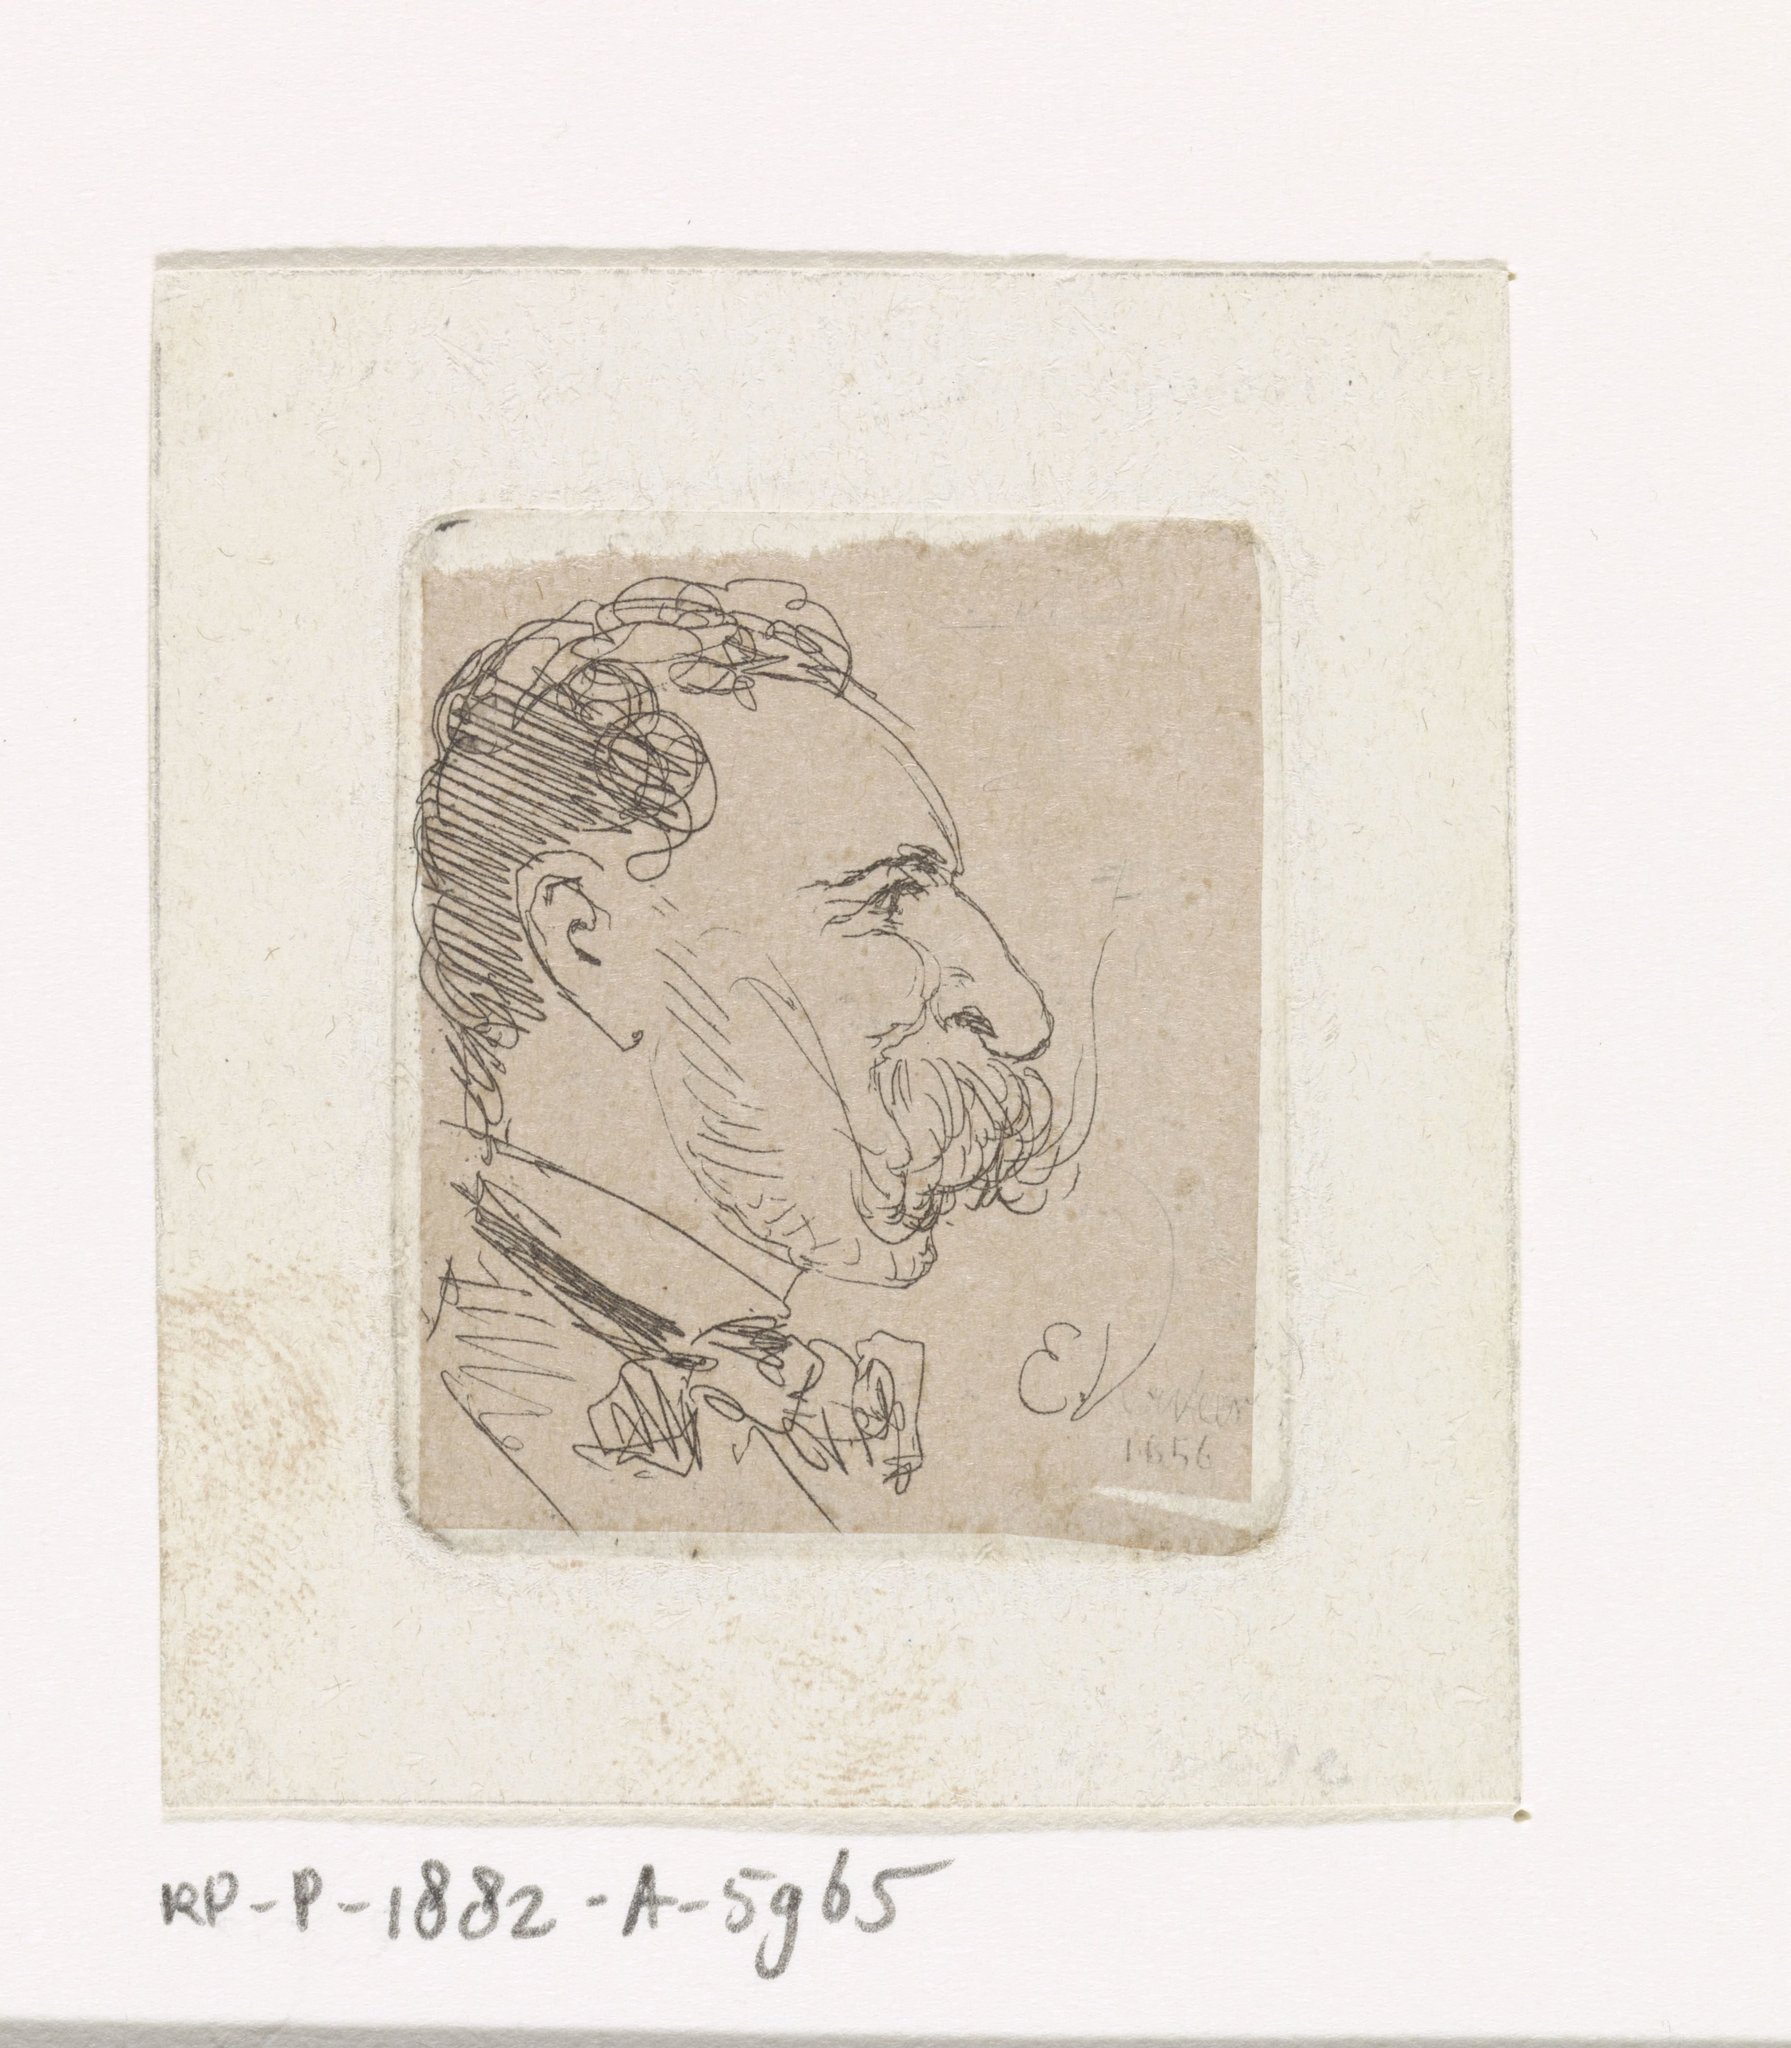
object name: print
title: Portret van Elchanon Verveer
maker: elchanon verveer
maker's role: draughtsman, print maker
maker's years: 1826-1900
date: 1856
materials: paper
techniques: etching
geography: the hague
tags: the hague, print maker, draughtsman, elchanon verveer, moustache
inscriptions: collector's mark: Lugt 2228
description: Zelfportret naar rechts van de kunstenaar Elchanon Verveer.